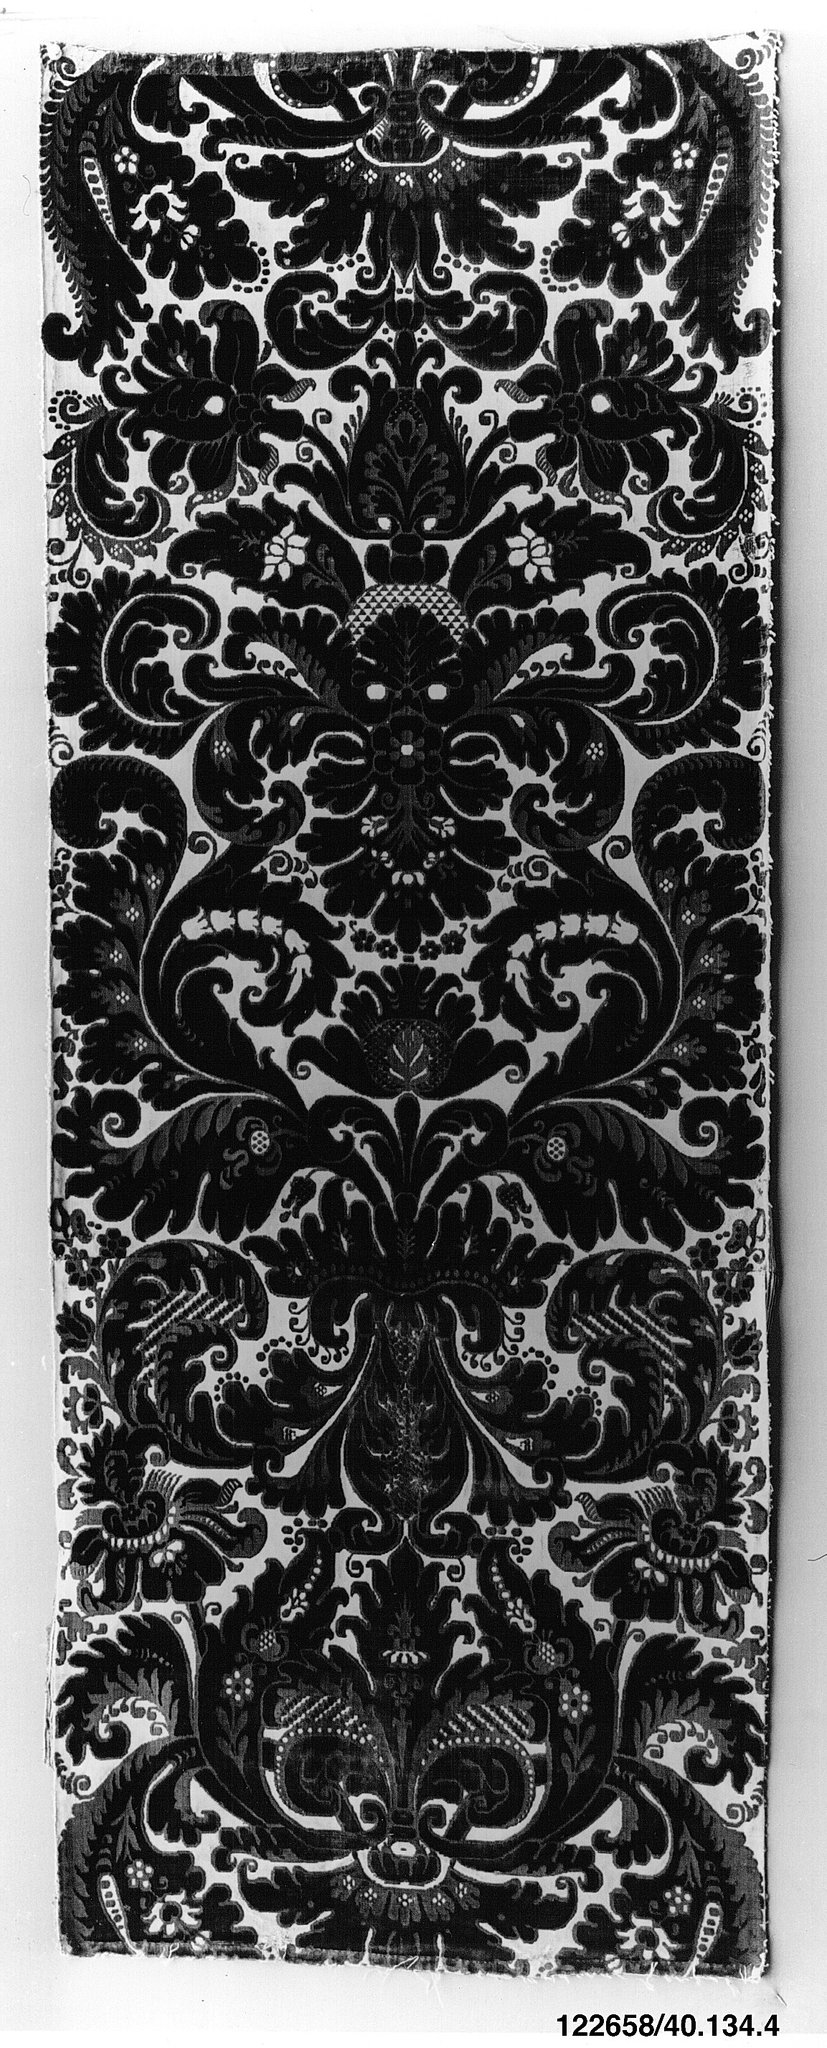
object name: piece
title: Length of furnishing velvet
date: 1711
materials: silk